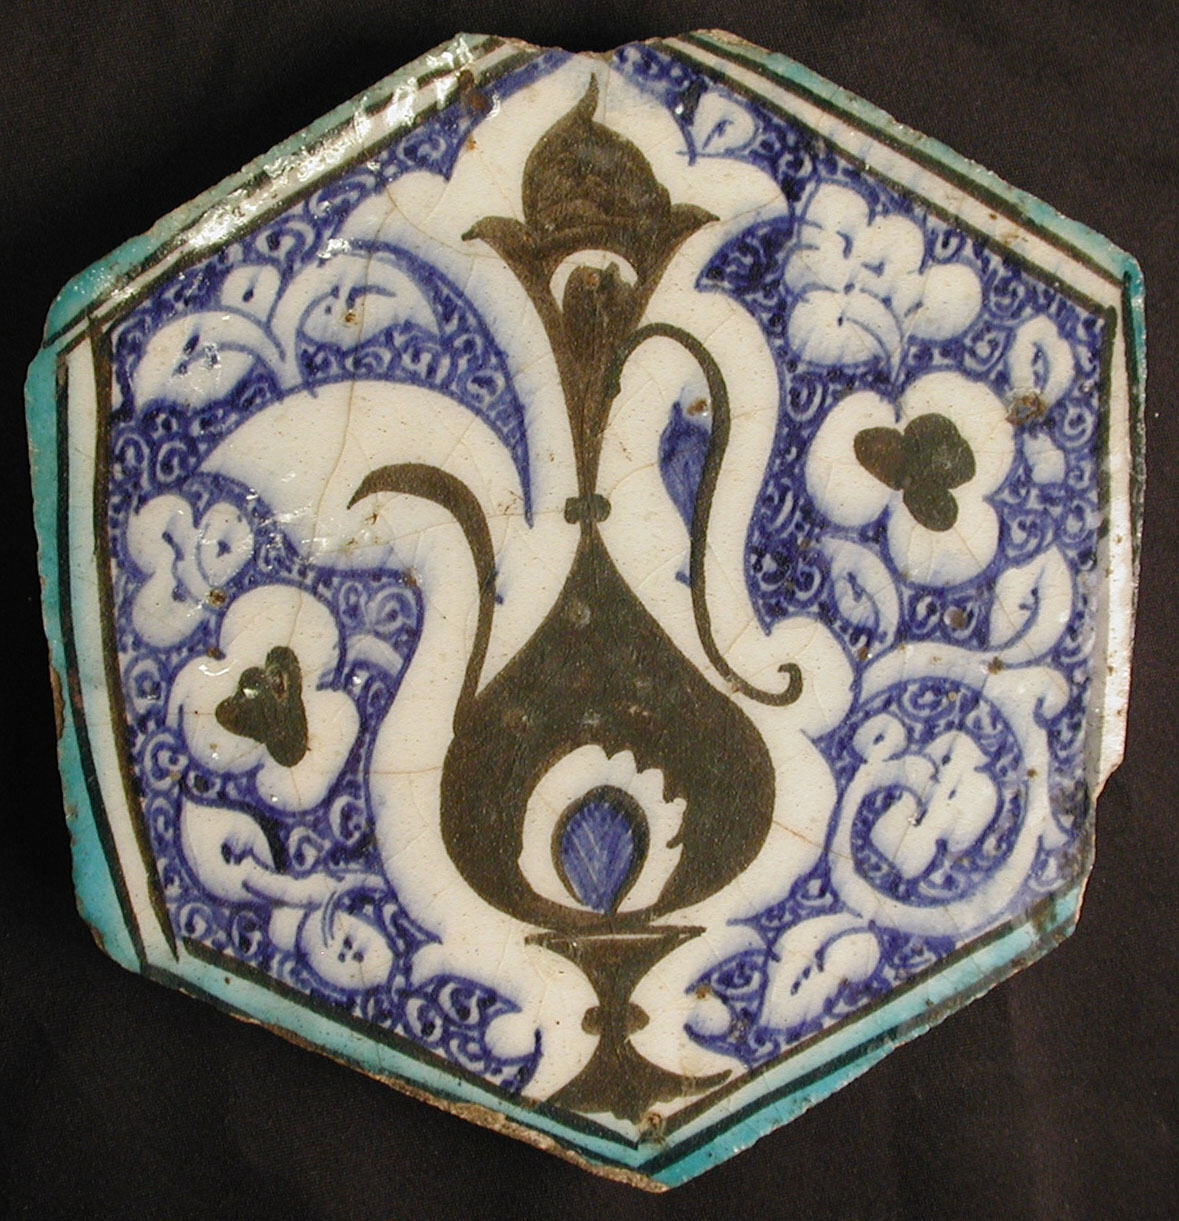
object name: tile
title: Hexagonal Tile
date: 1401-1450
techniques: painting, underglaze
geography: syria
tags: ewers